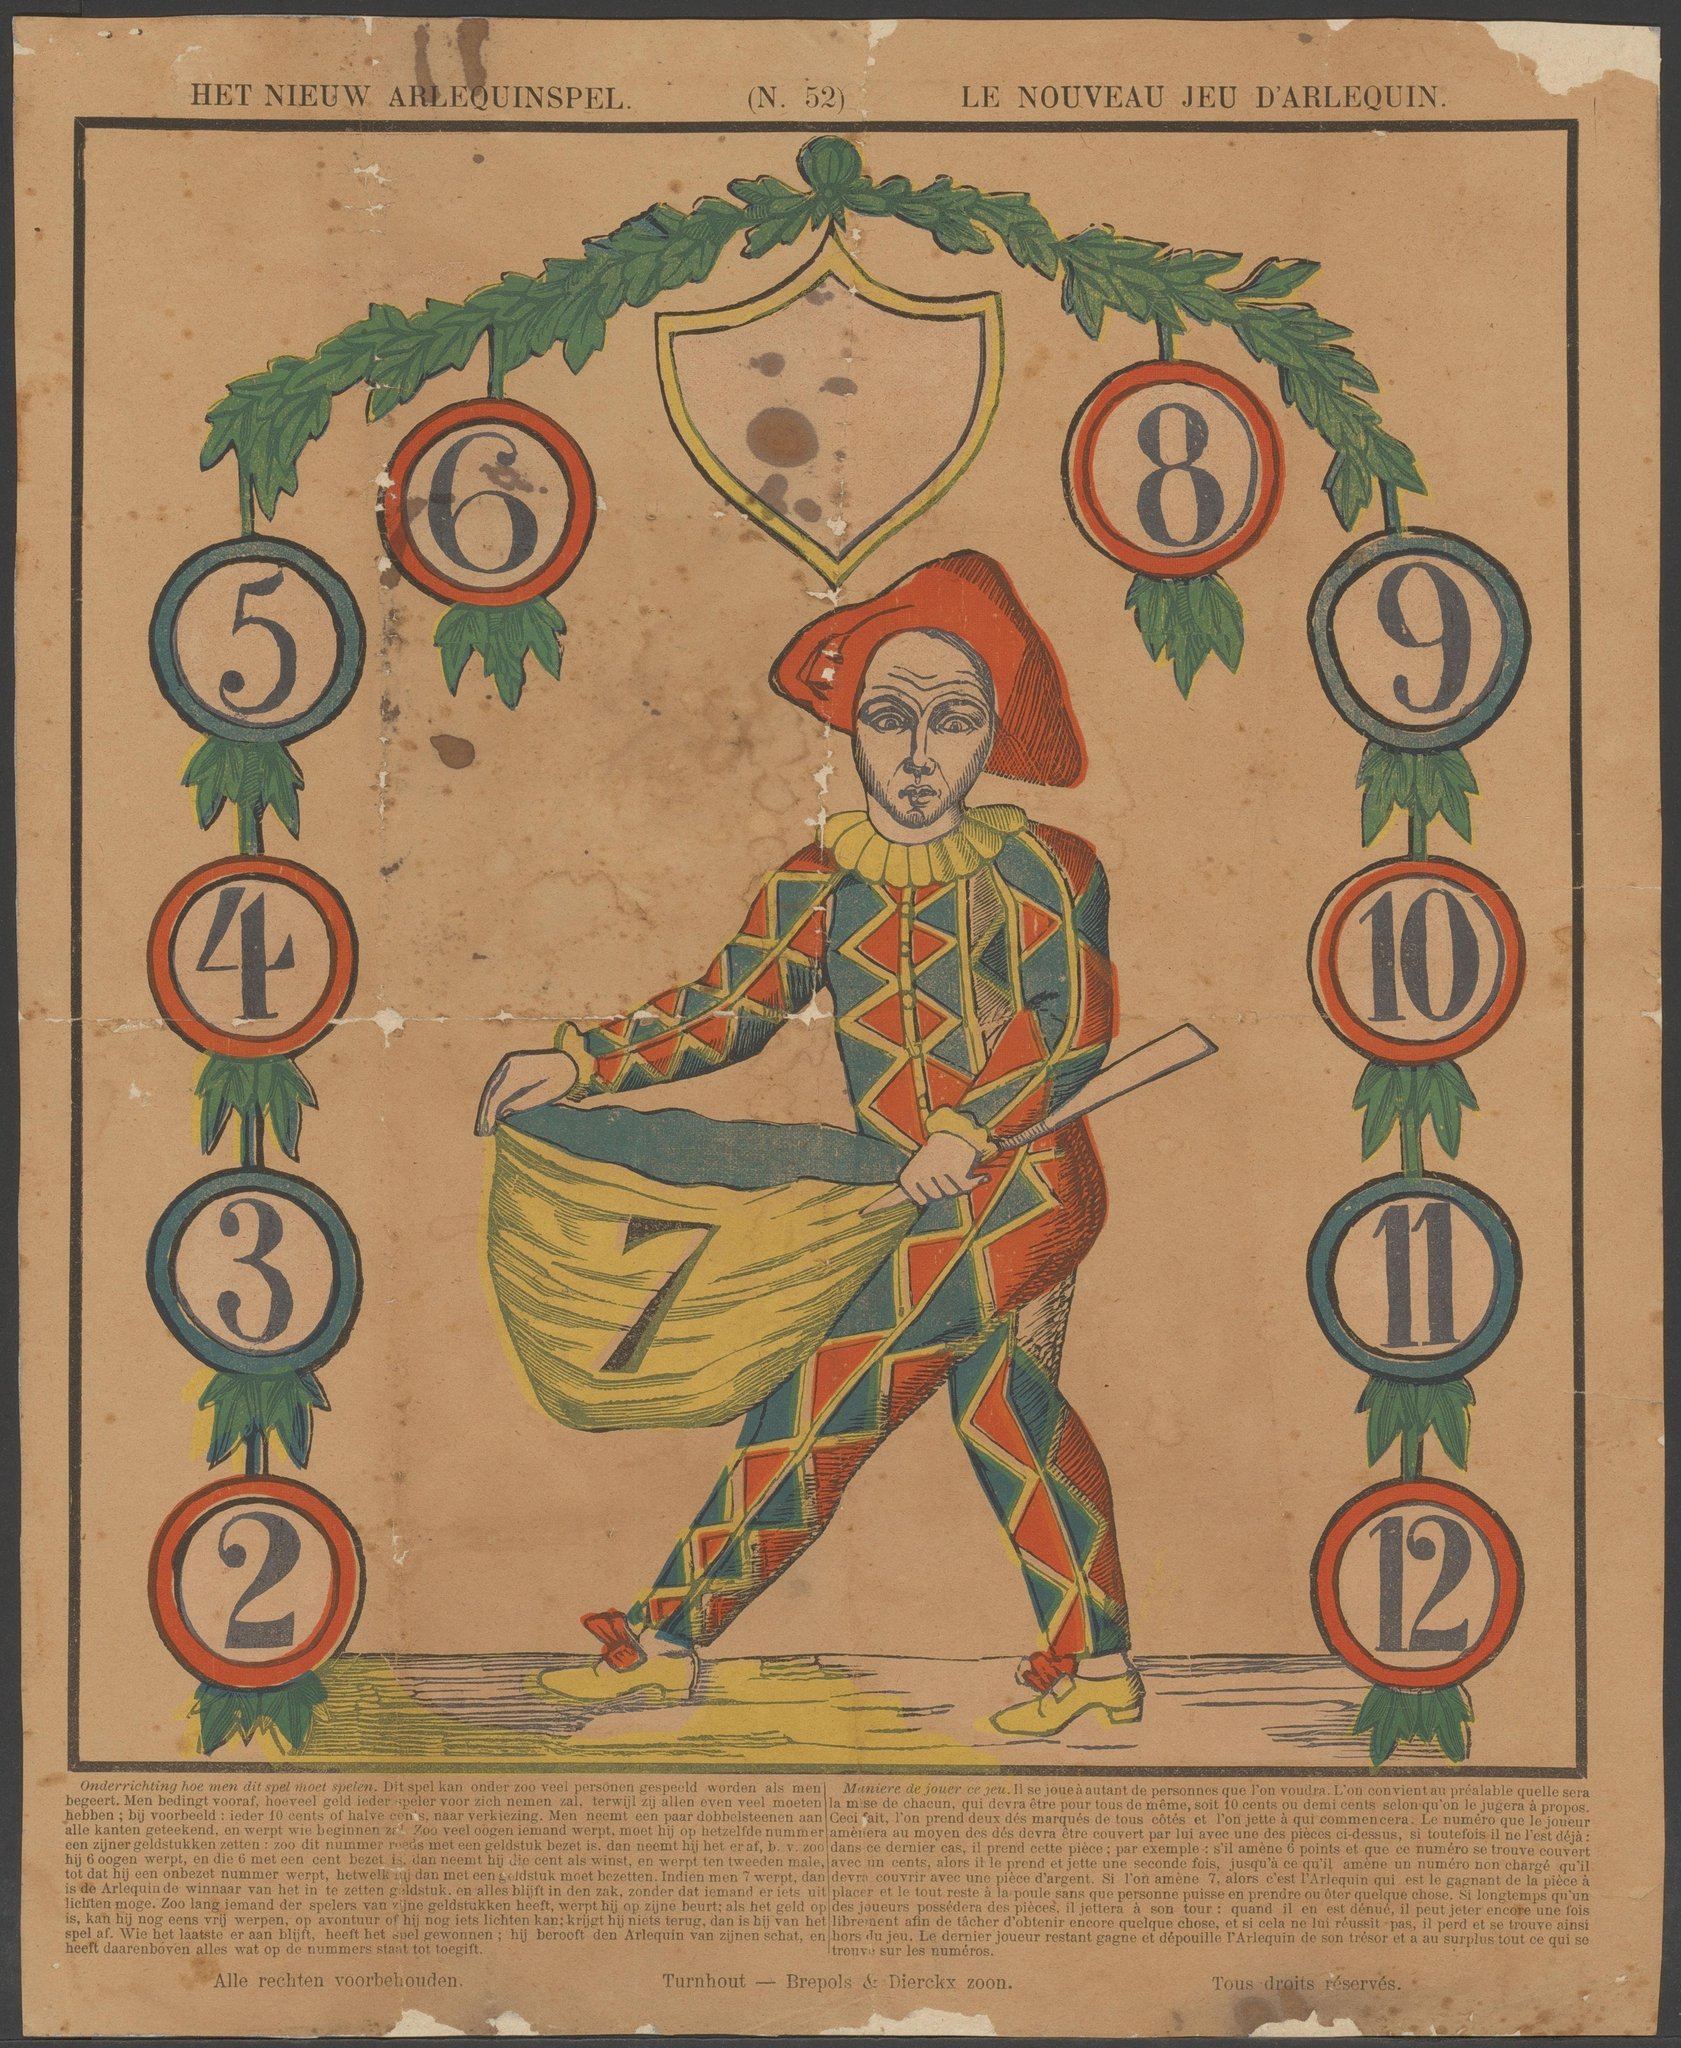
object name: popular print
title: Speelbord met harlekijn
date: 1800-1833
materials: paper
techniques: hand coloring, letterpress printing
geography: turnhout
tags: board-games of chance, types in 'commedia dell'arte': harlequin, board-games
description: Bordspel met in het midden van het speelveld een harlekijn die in zijn geopende handen een zak houdt met daarop het cijfer 7. Rondom hem een guirlande waaraan medaillons hangen met de cijfers 2 tot en met 12. Bovenaan in het midden een schild. Onder de voorstelling de spelregels in het Nederlands en in het Frans in twee kolommen. Genummerd midden boven: N. 52. Onderwerpsrubrieken binnen de Atlas Zeden en Gewoonten: Zeden en gewoonten in engeren zin, Spel en vermaak, Gezelschapsspel II, Ganzenbord en dergelijke.